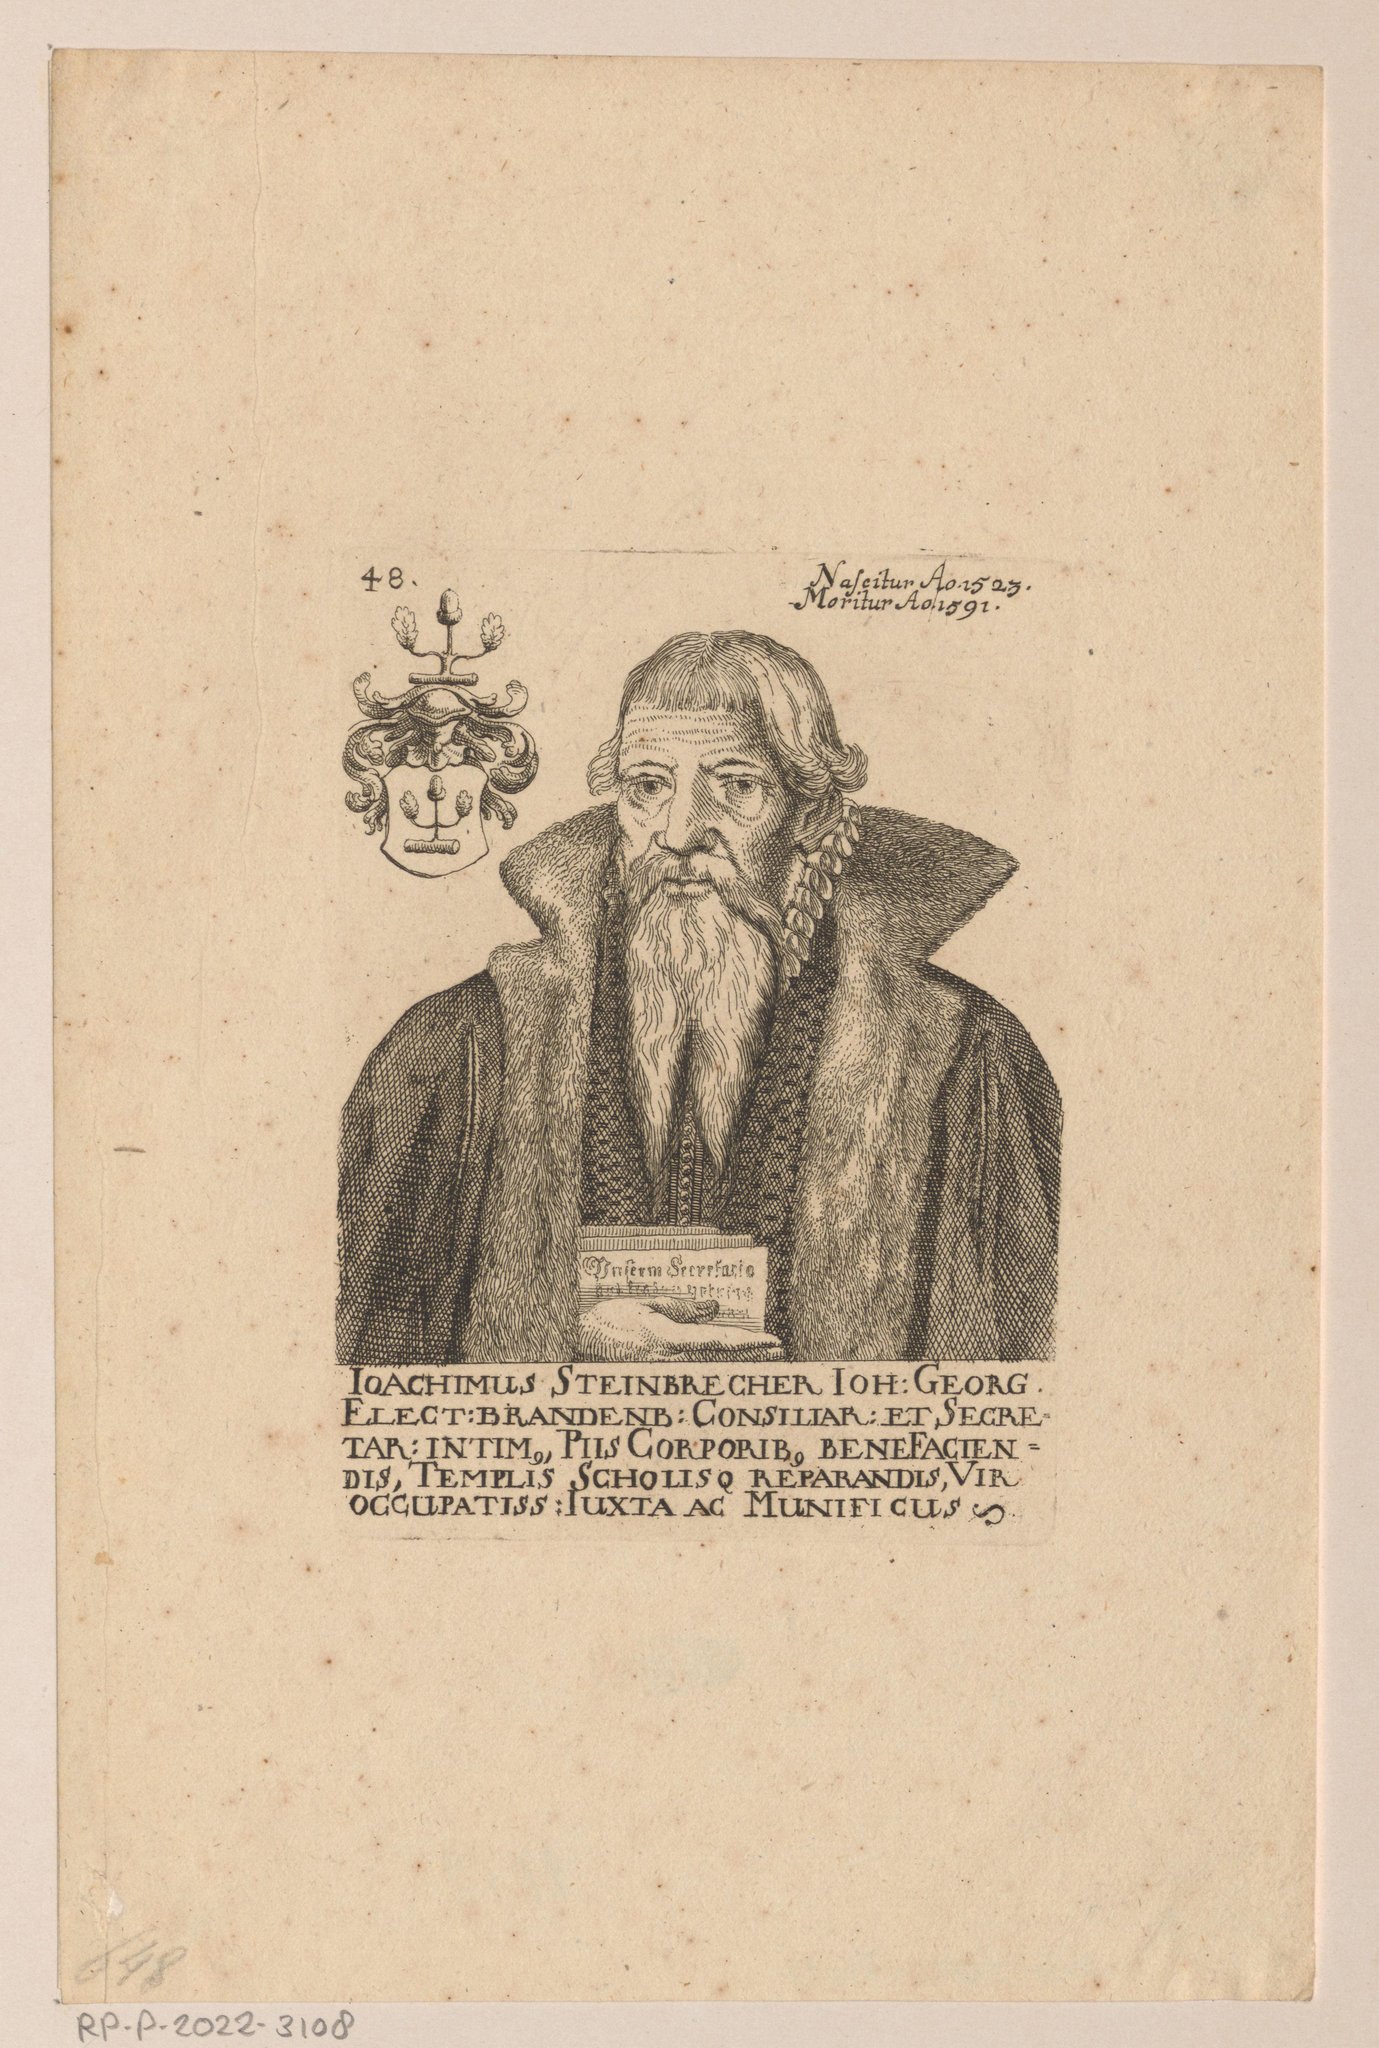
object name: print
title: Illustere mannen verzameld door Martin Friedrich Seidel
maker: Anonymous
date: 1671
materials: paper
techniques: etching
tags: historical persons, lawyer, attorney at law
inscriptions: collector's mark: Lugt 2228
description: De prent is uitgegeven als onderdeel van een serie. Later is de prent mogelijk ook als boekillustratie gebruikt in: Küster, Georg Gottfried. Martin Friedrich Seidels Bilder-Sammlung in welcher hundert, gröstentheils in der Mark Brandenburg (…). Berlijn: Buchladen bey der Real-Schule, 1751. Het is onduidelijk tot welke uitgave de huidige prent behoort.